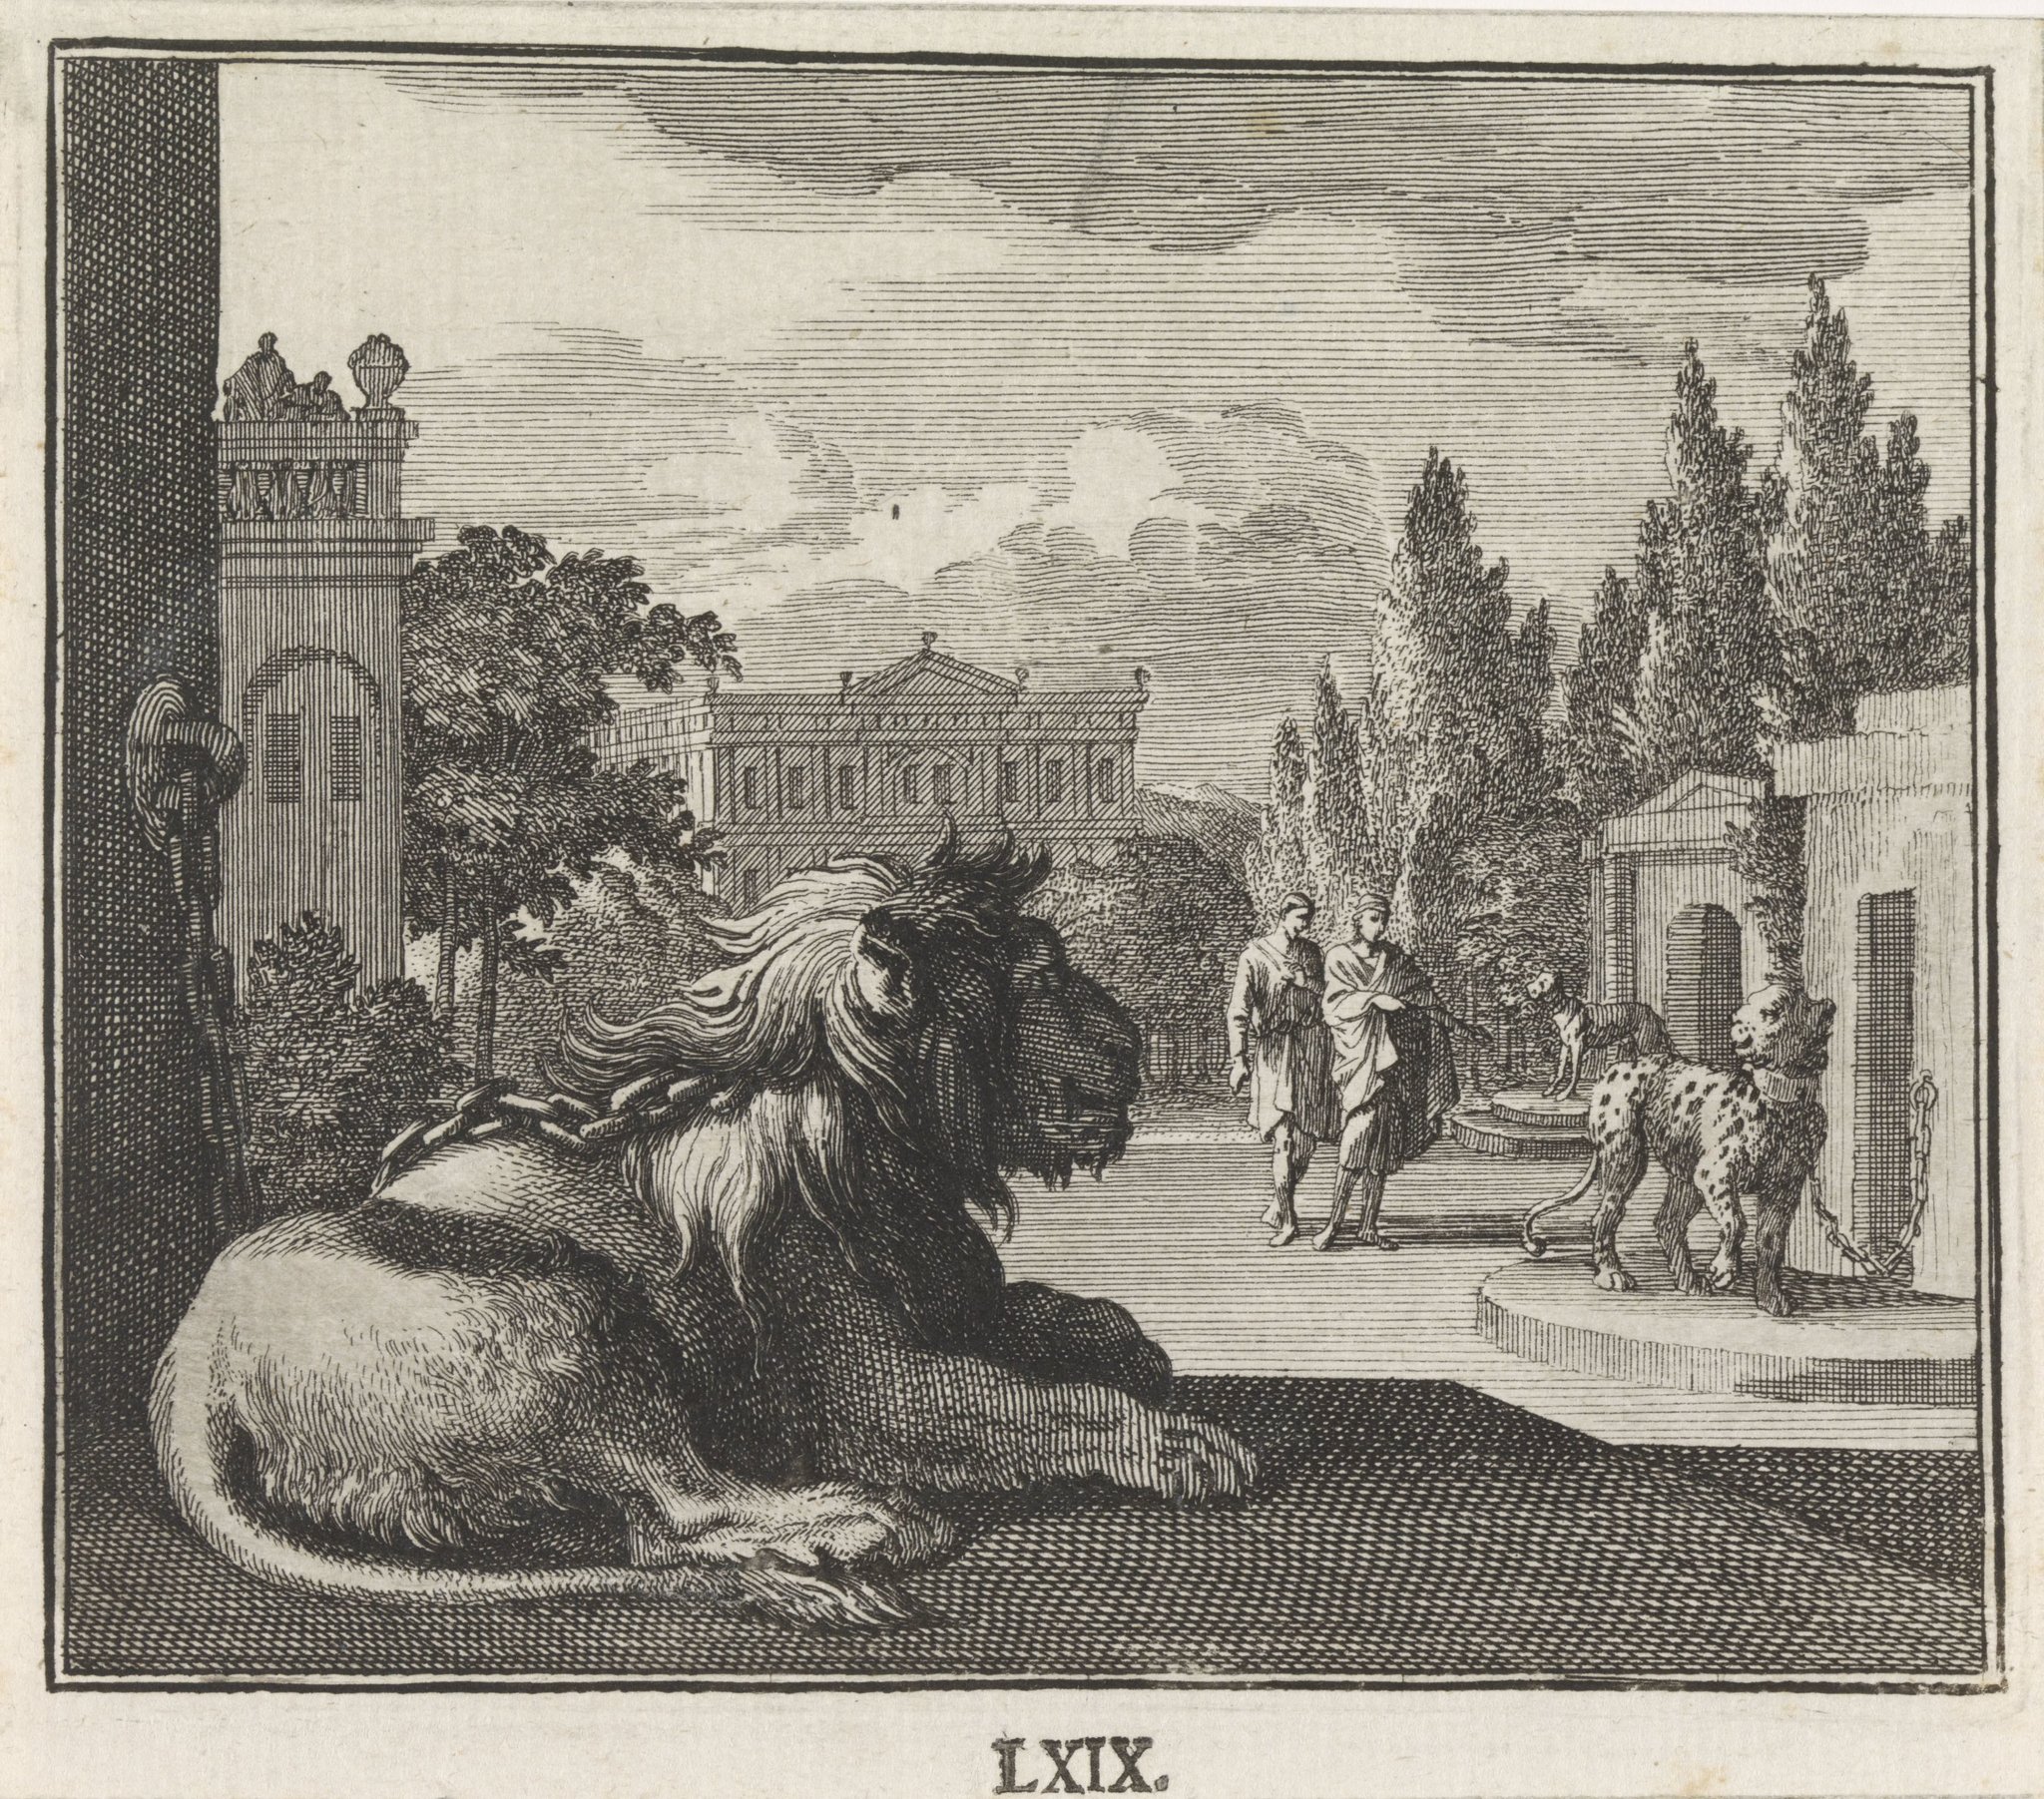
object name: print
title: Embleem: wilde dieren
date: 1695-1705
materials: paper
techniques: etching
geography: nuremberg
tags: beasts of prey, predatory animals: leopard, zoological garden, zoo, seen as place where non-domestic animals are kept, beasts of prey, predatory animals: lion, abstract ideas and concepts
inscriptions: collector's mark: Lugt 2228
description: Boekillustratie voor Weigel, Christoph. Ethica Naturalis seu Documenta Moralia e Variis rerum Naturalium proprietatibus Virtutum Vitiorumq symbolicis imaginibus collecta. Neurenberg: Christoph Weigel: c. 1700.